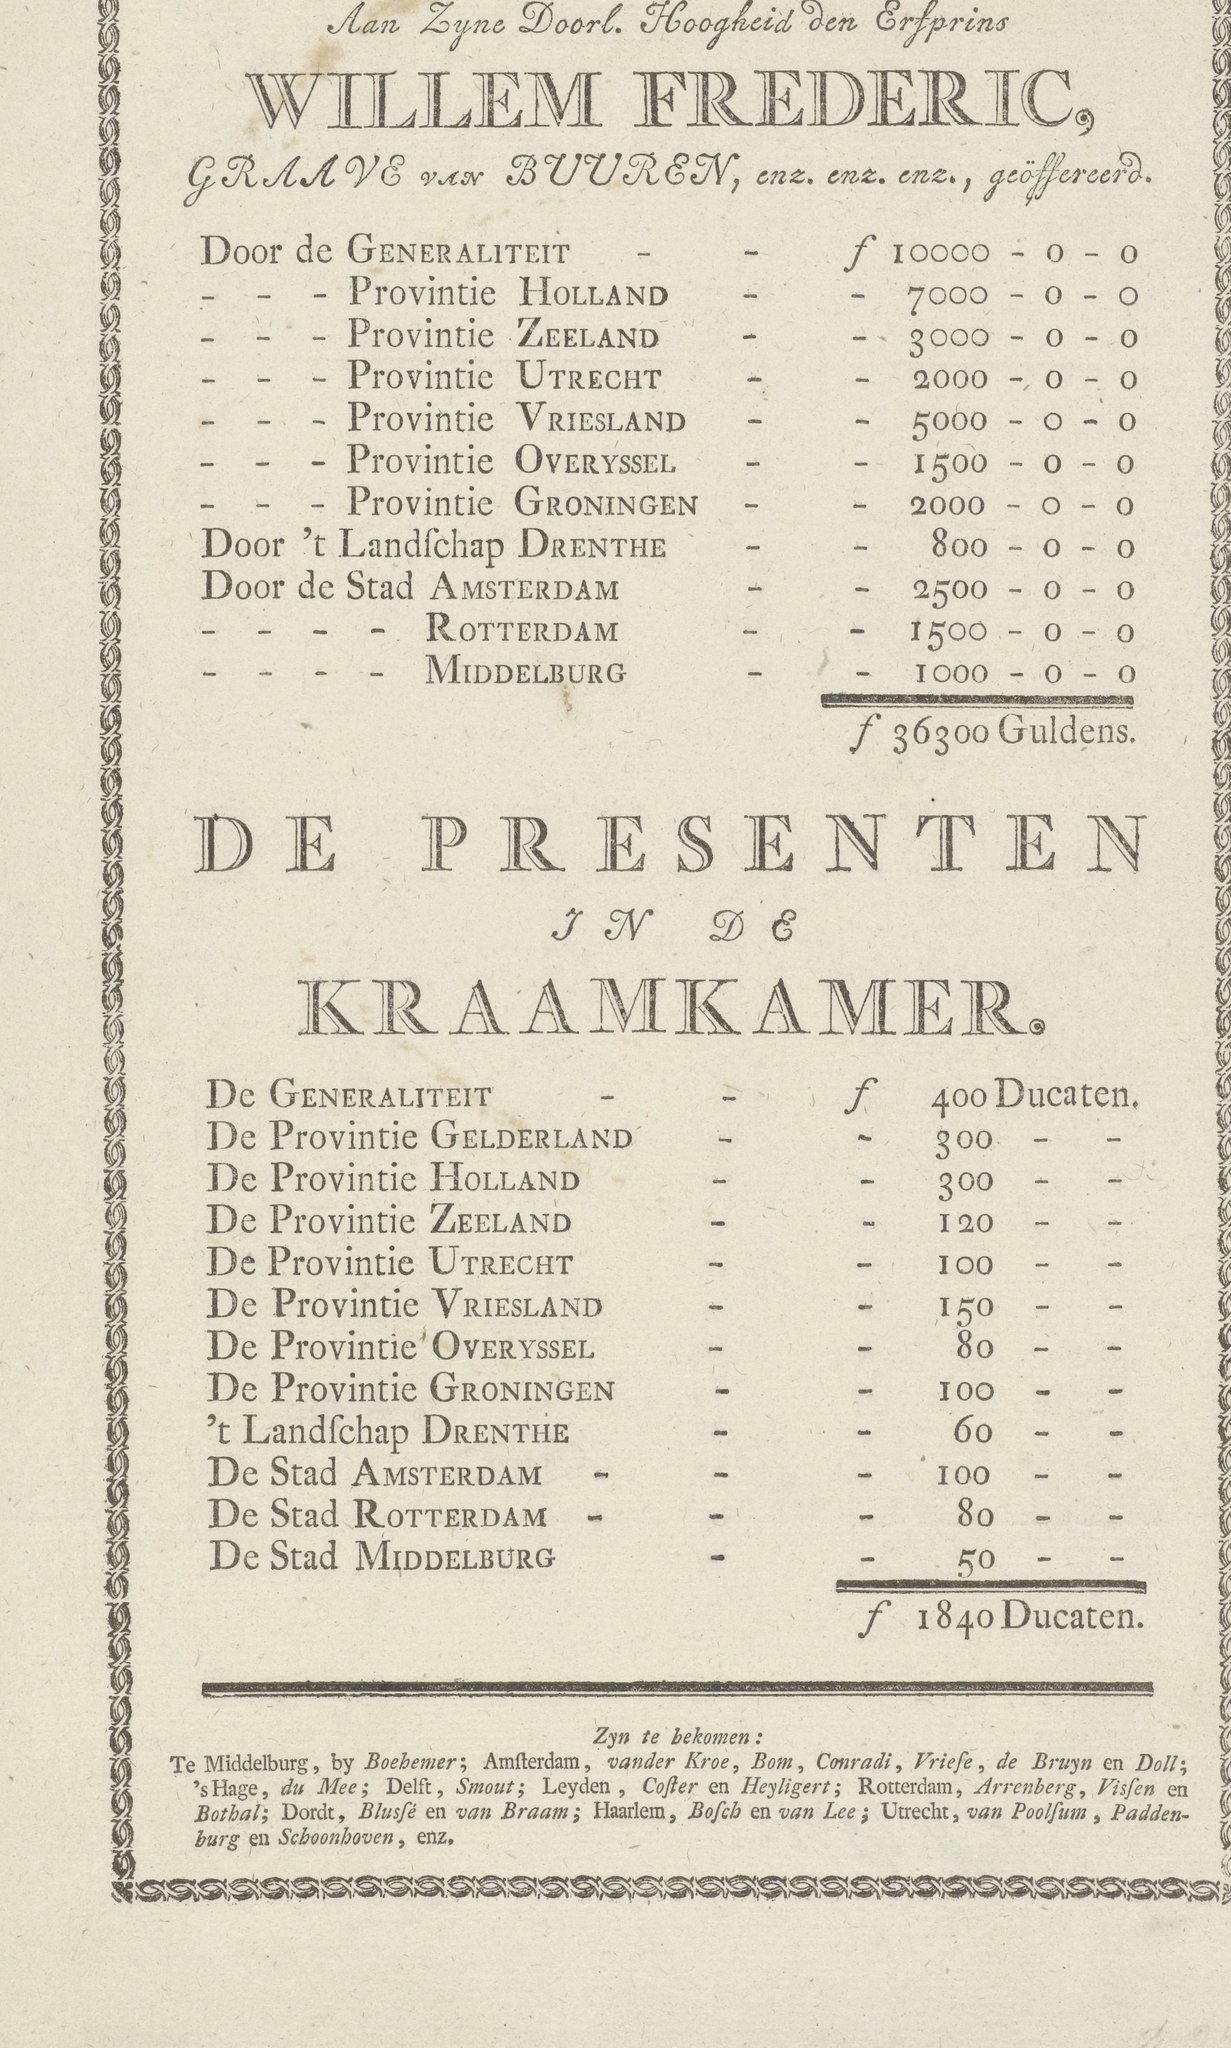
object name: text sheet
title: Lyst der Pillegiften, Aan Zyne Doorl. Hoogheid den Erfprins Willem Frederic, Graave van Buuren, (...), geöffereerd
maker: Anonymous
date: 1772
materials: paper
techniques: letterpress printing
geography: northern netherlands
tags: the hague, berlin, william i of the netherlands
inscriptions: collector's mark: Lugt 2228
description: Tekstblad met een lijst van pillegiften en presenten in de kraamkamer, geschonken door provincies en steden aan prins Willem Frederik bij zijn doop op 17 september 1772. Onderaan een lijst van alle verkopers in verschillende steden waar deze lijst verkrijgbaar is.